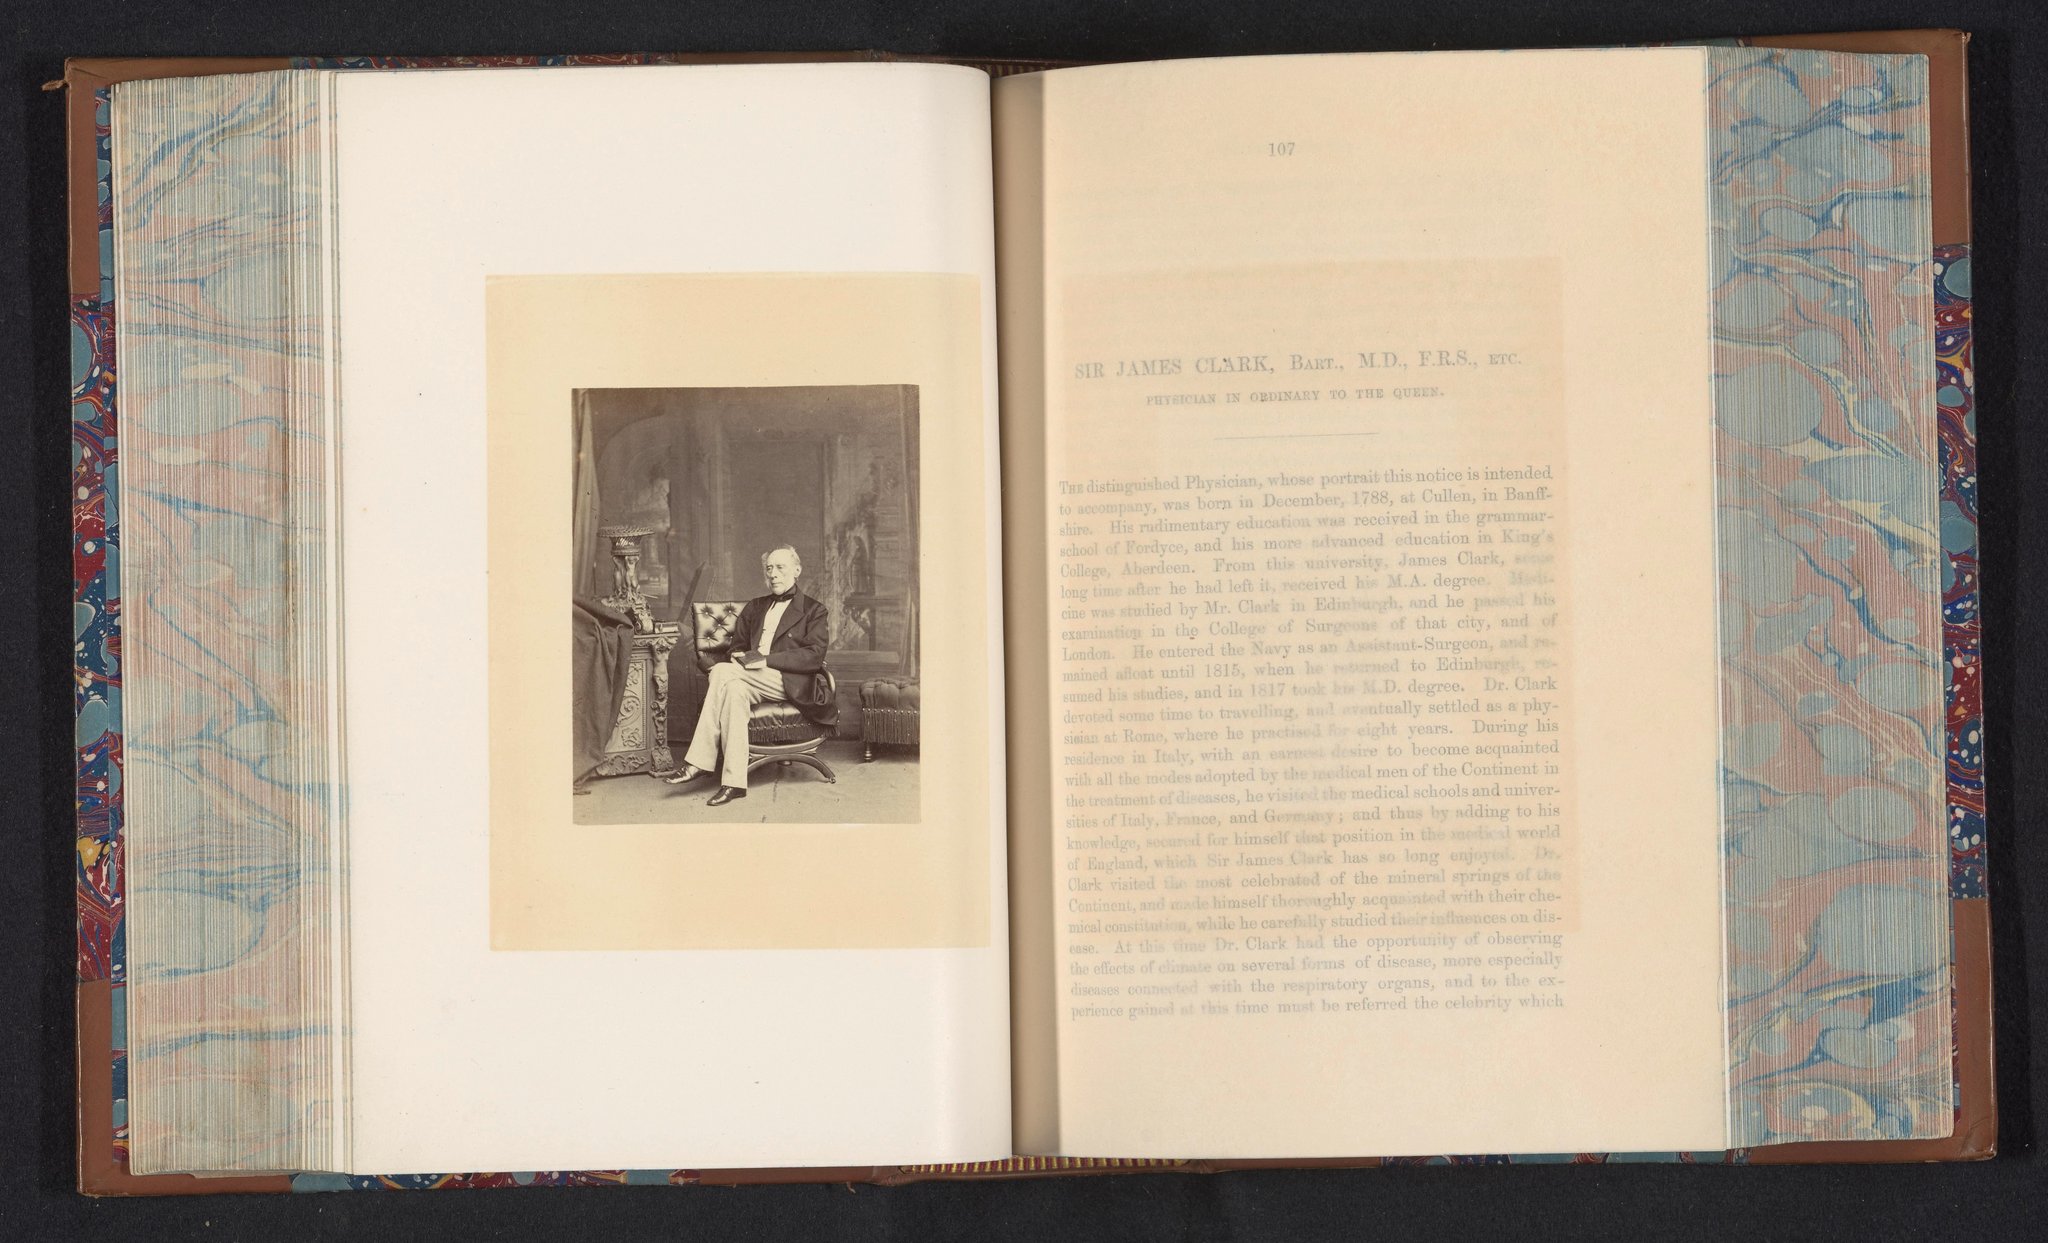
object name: page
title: Portret van Sir James Clark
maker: ernest edwards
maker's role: fotograaf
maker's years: 1837-1903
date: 1853-1867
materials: photographic support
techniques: albumen print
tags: studio requisites ~ photographer, physician, doctor